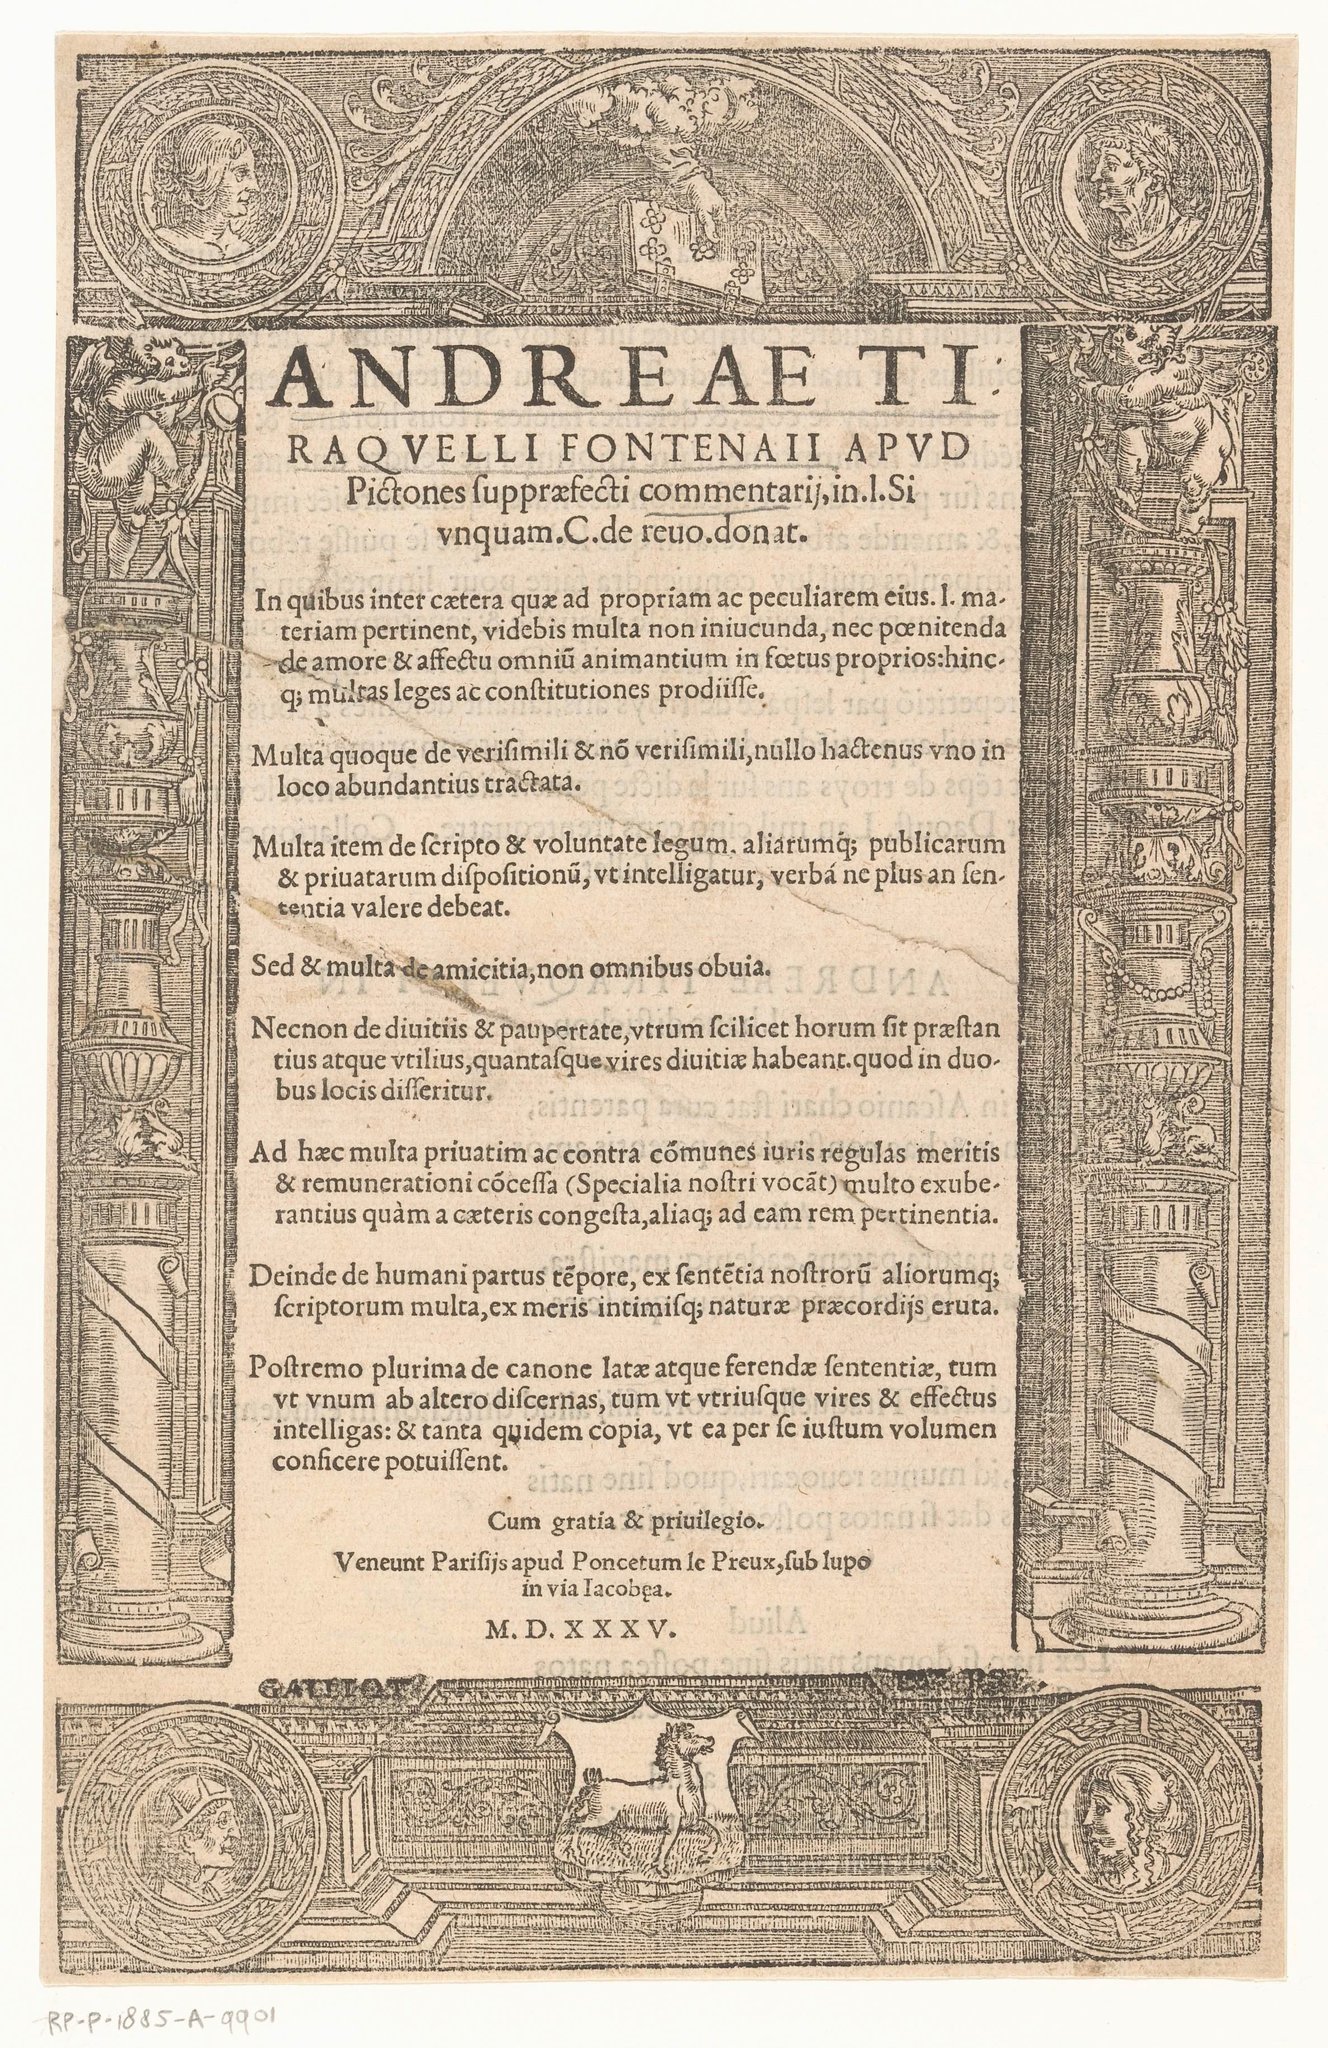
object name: titelblad, titelpagina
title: Titelpagina voor een publicatie van André Tiraqueau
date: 1535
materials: paper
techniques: woodcut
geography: paris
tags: paris, ornament derived from architectural details, cupids: 'amores', 'amoretti', 'putti'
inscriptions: collector's mark: Lugt 2228